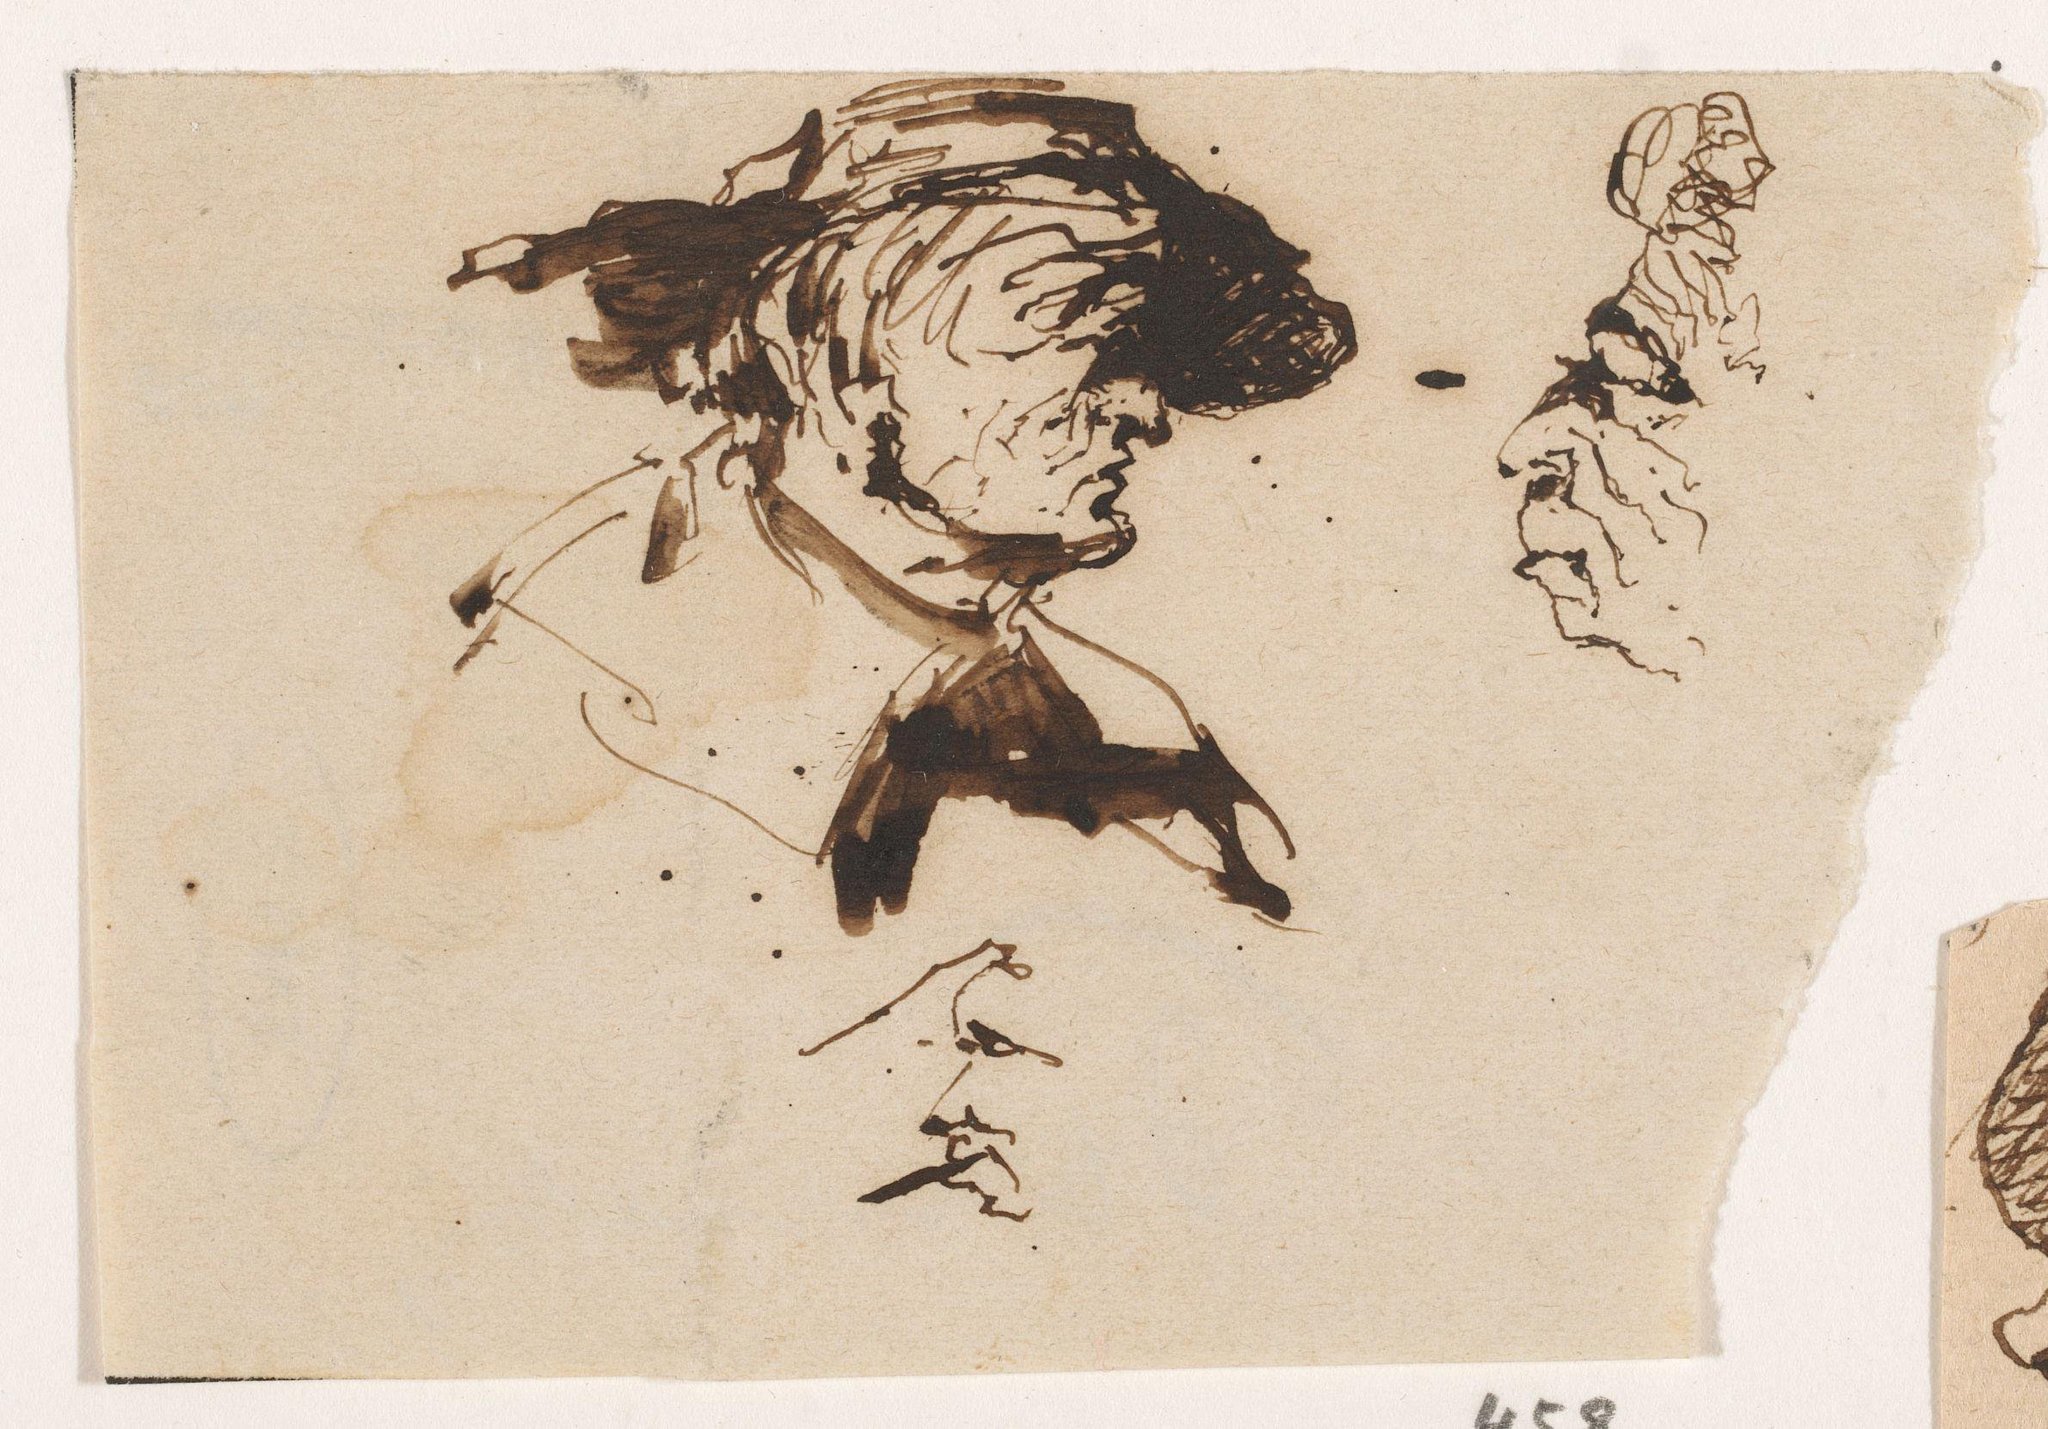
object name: drawing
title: Koppen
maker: johannes tavenraat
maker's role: draughtsman, painter, print maker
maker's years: 1809-1881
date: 1840-1880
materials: ink, paper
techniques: brush, pen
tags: caricatures (human types)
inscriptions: collector's mark: Lugt 2228, signature: ‘Tavenraat’